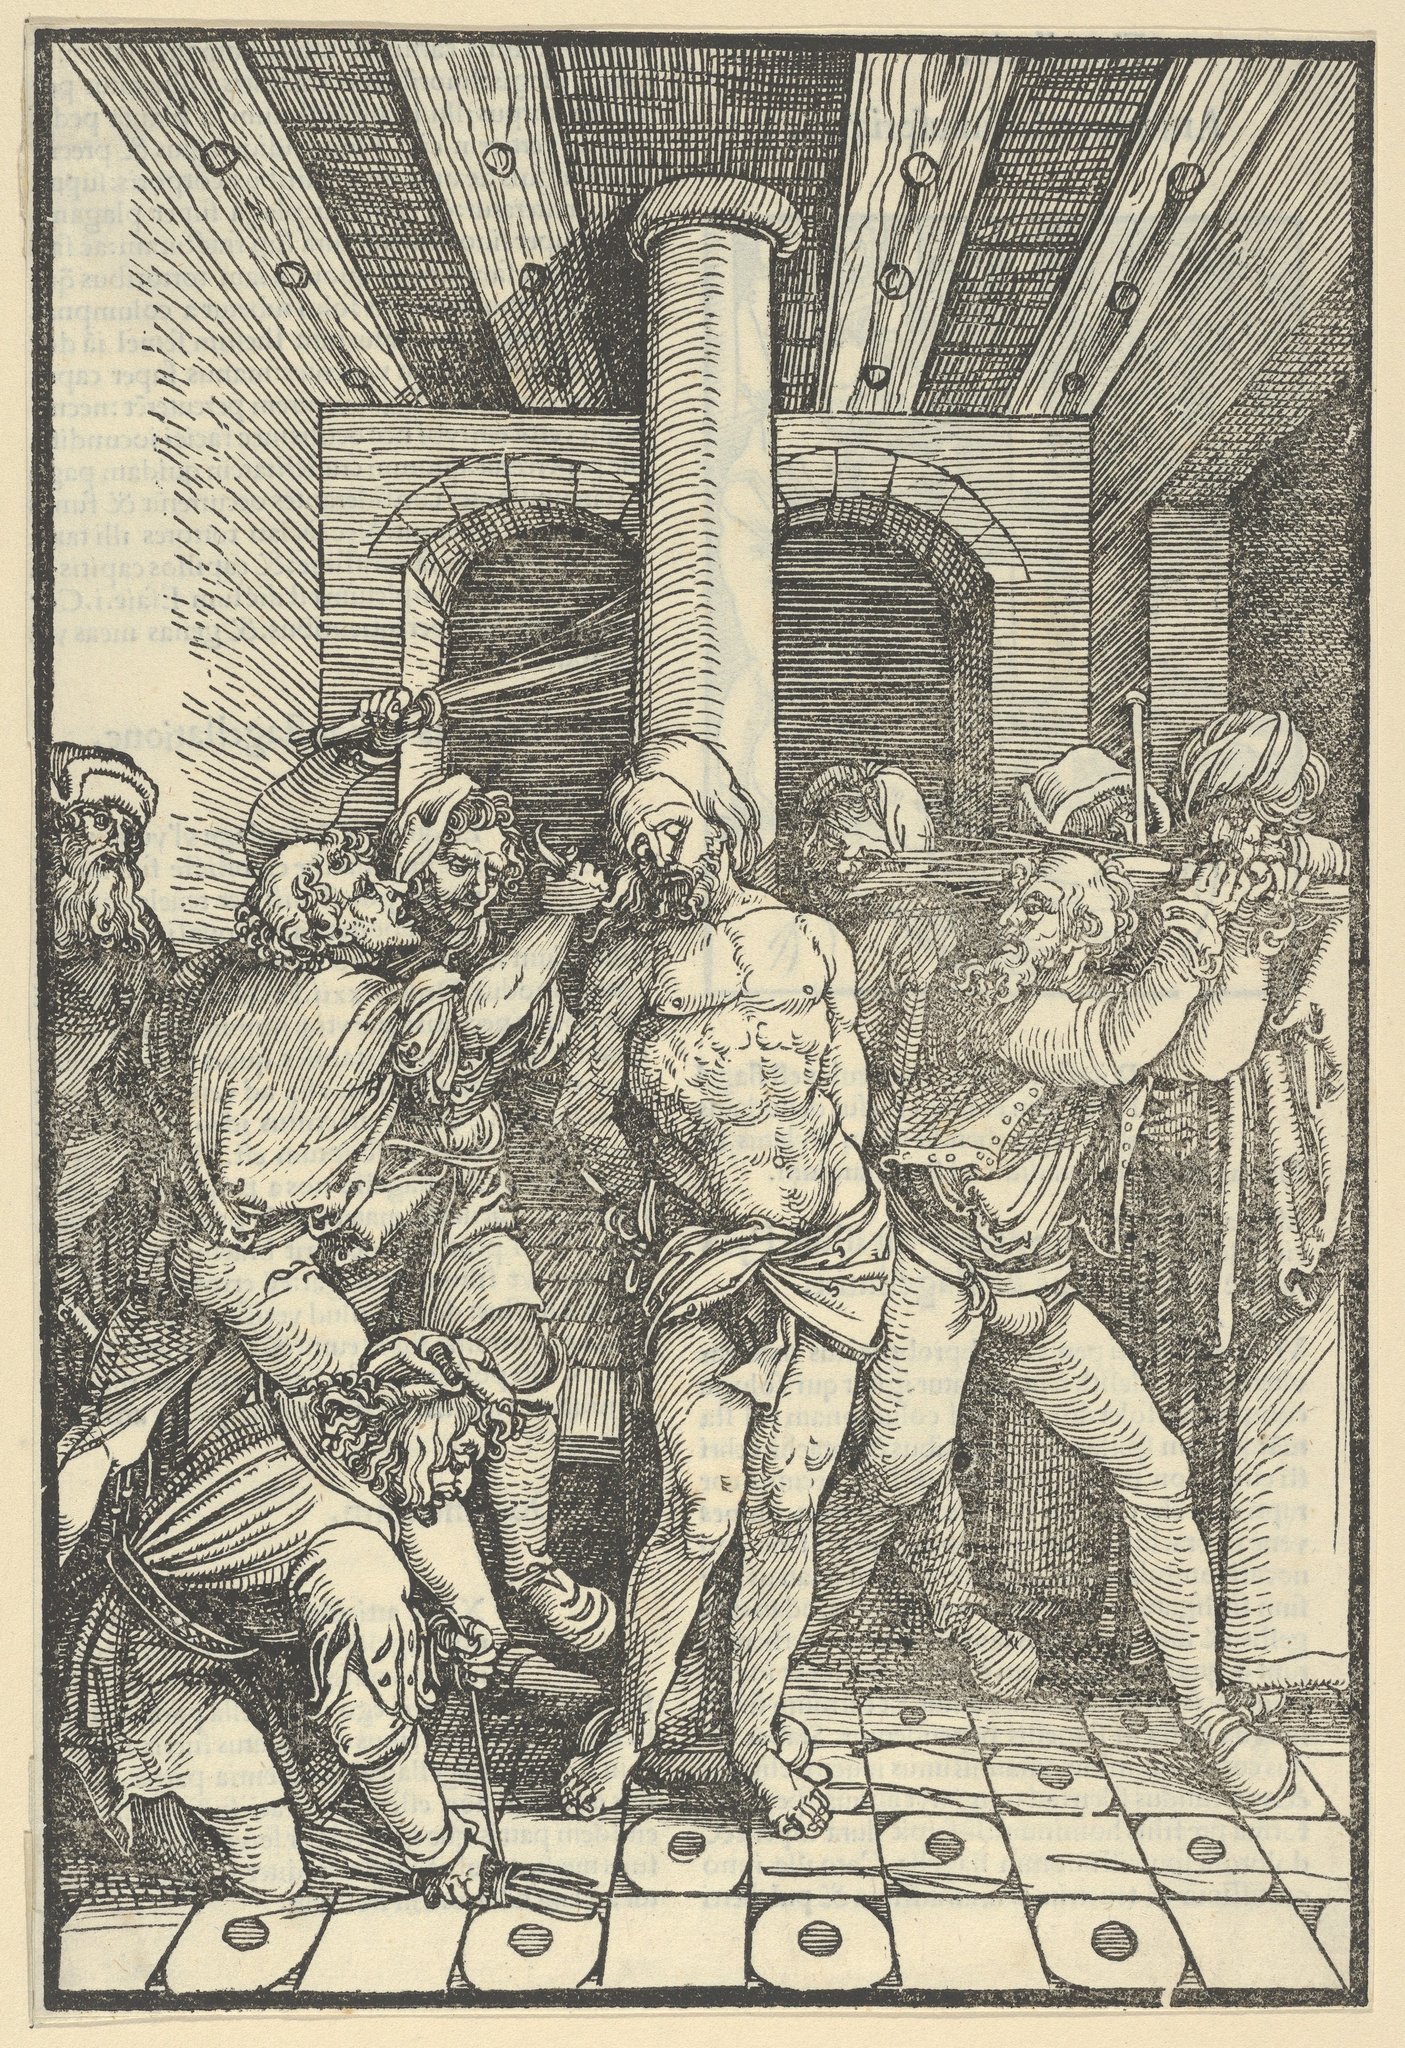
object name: print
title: Christ Scourged, from Speculum passionis domini nostri Ihesu Christi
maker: hans schäufelein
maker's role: artist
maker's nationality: german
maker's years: 1480-1540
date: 1507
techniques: woodcut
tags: suffering,men,christ